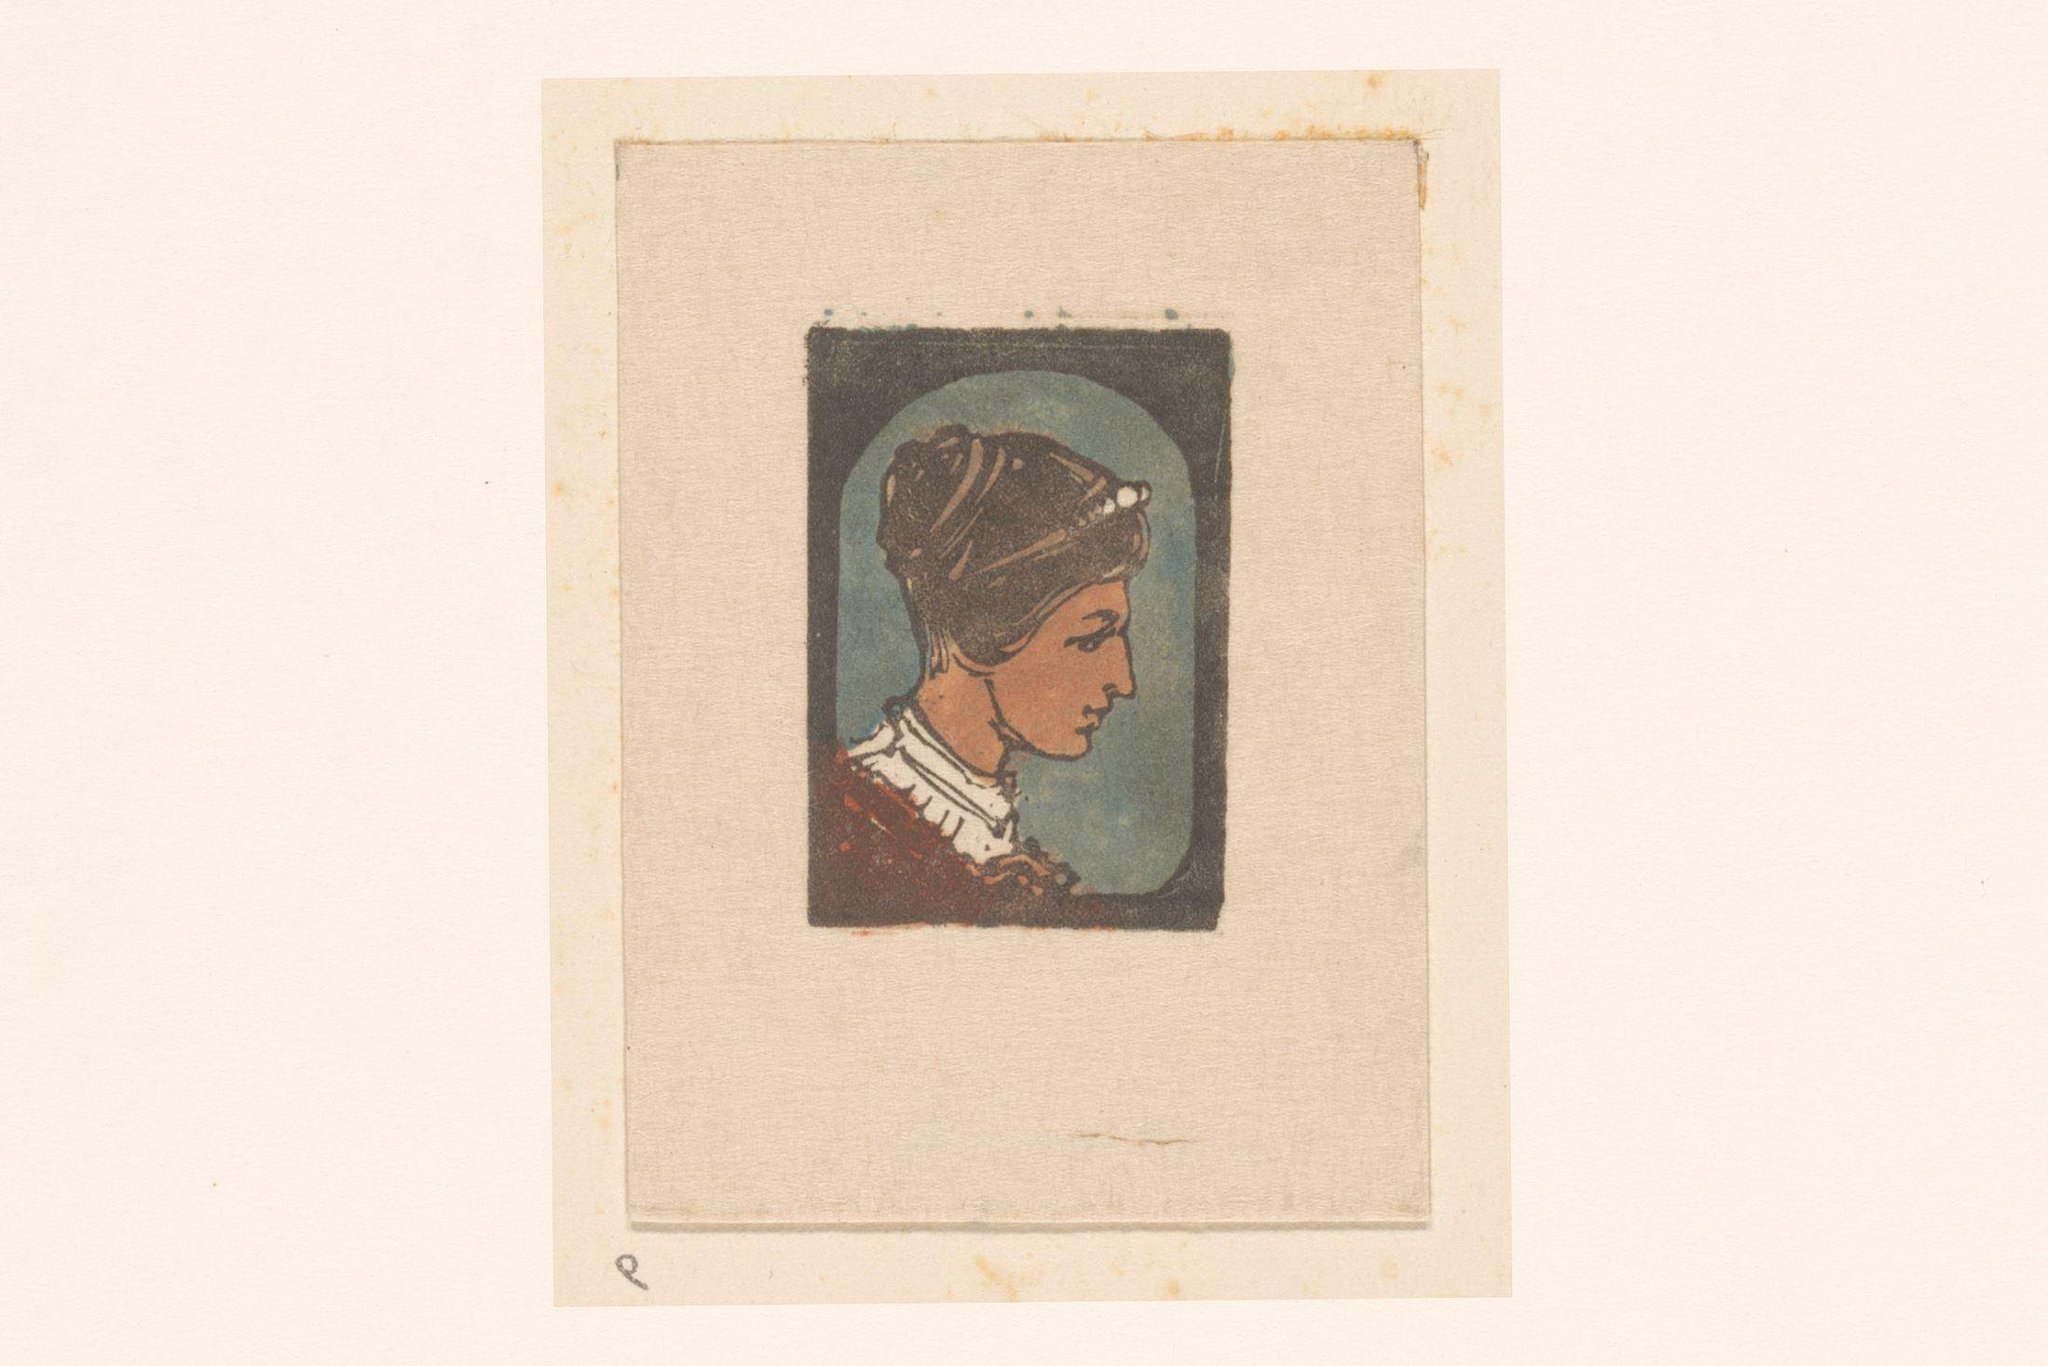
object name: print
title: Hoofd van een vrouw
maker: bernard willem wierink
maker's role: draughtsman, print maker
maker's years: 1856-1939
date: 1866-1939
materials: paper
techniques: relief print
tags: anonymous historical person portrayed - bb - woman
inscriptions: collector's mark: Lugt 2228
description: Deze prent is vermoedelijk een plaatsnede, ook al wordt in de literatuur veelal gesproken over een houtsnede. Voor zover Wierink zijn prenten in hoogdruk zelf nader heeft omschreven, heeft hij altijd de term 'plaatsnede' gebruikt.